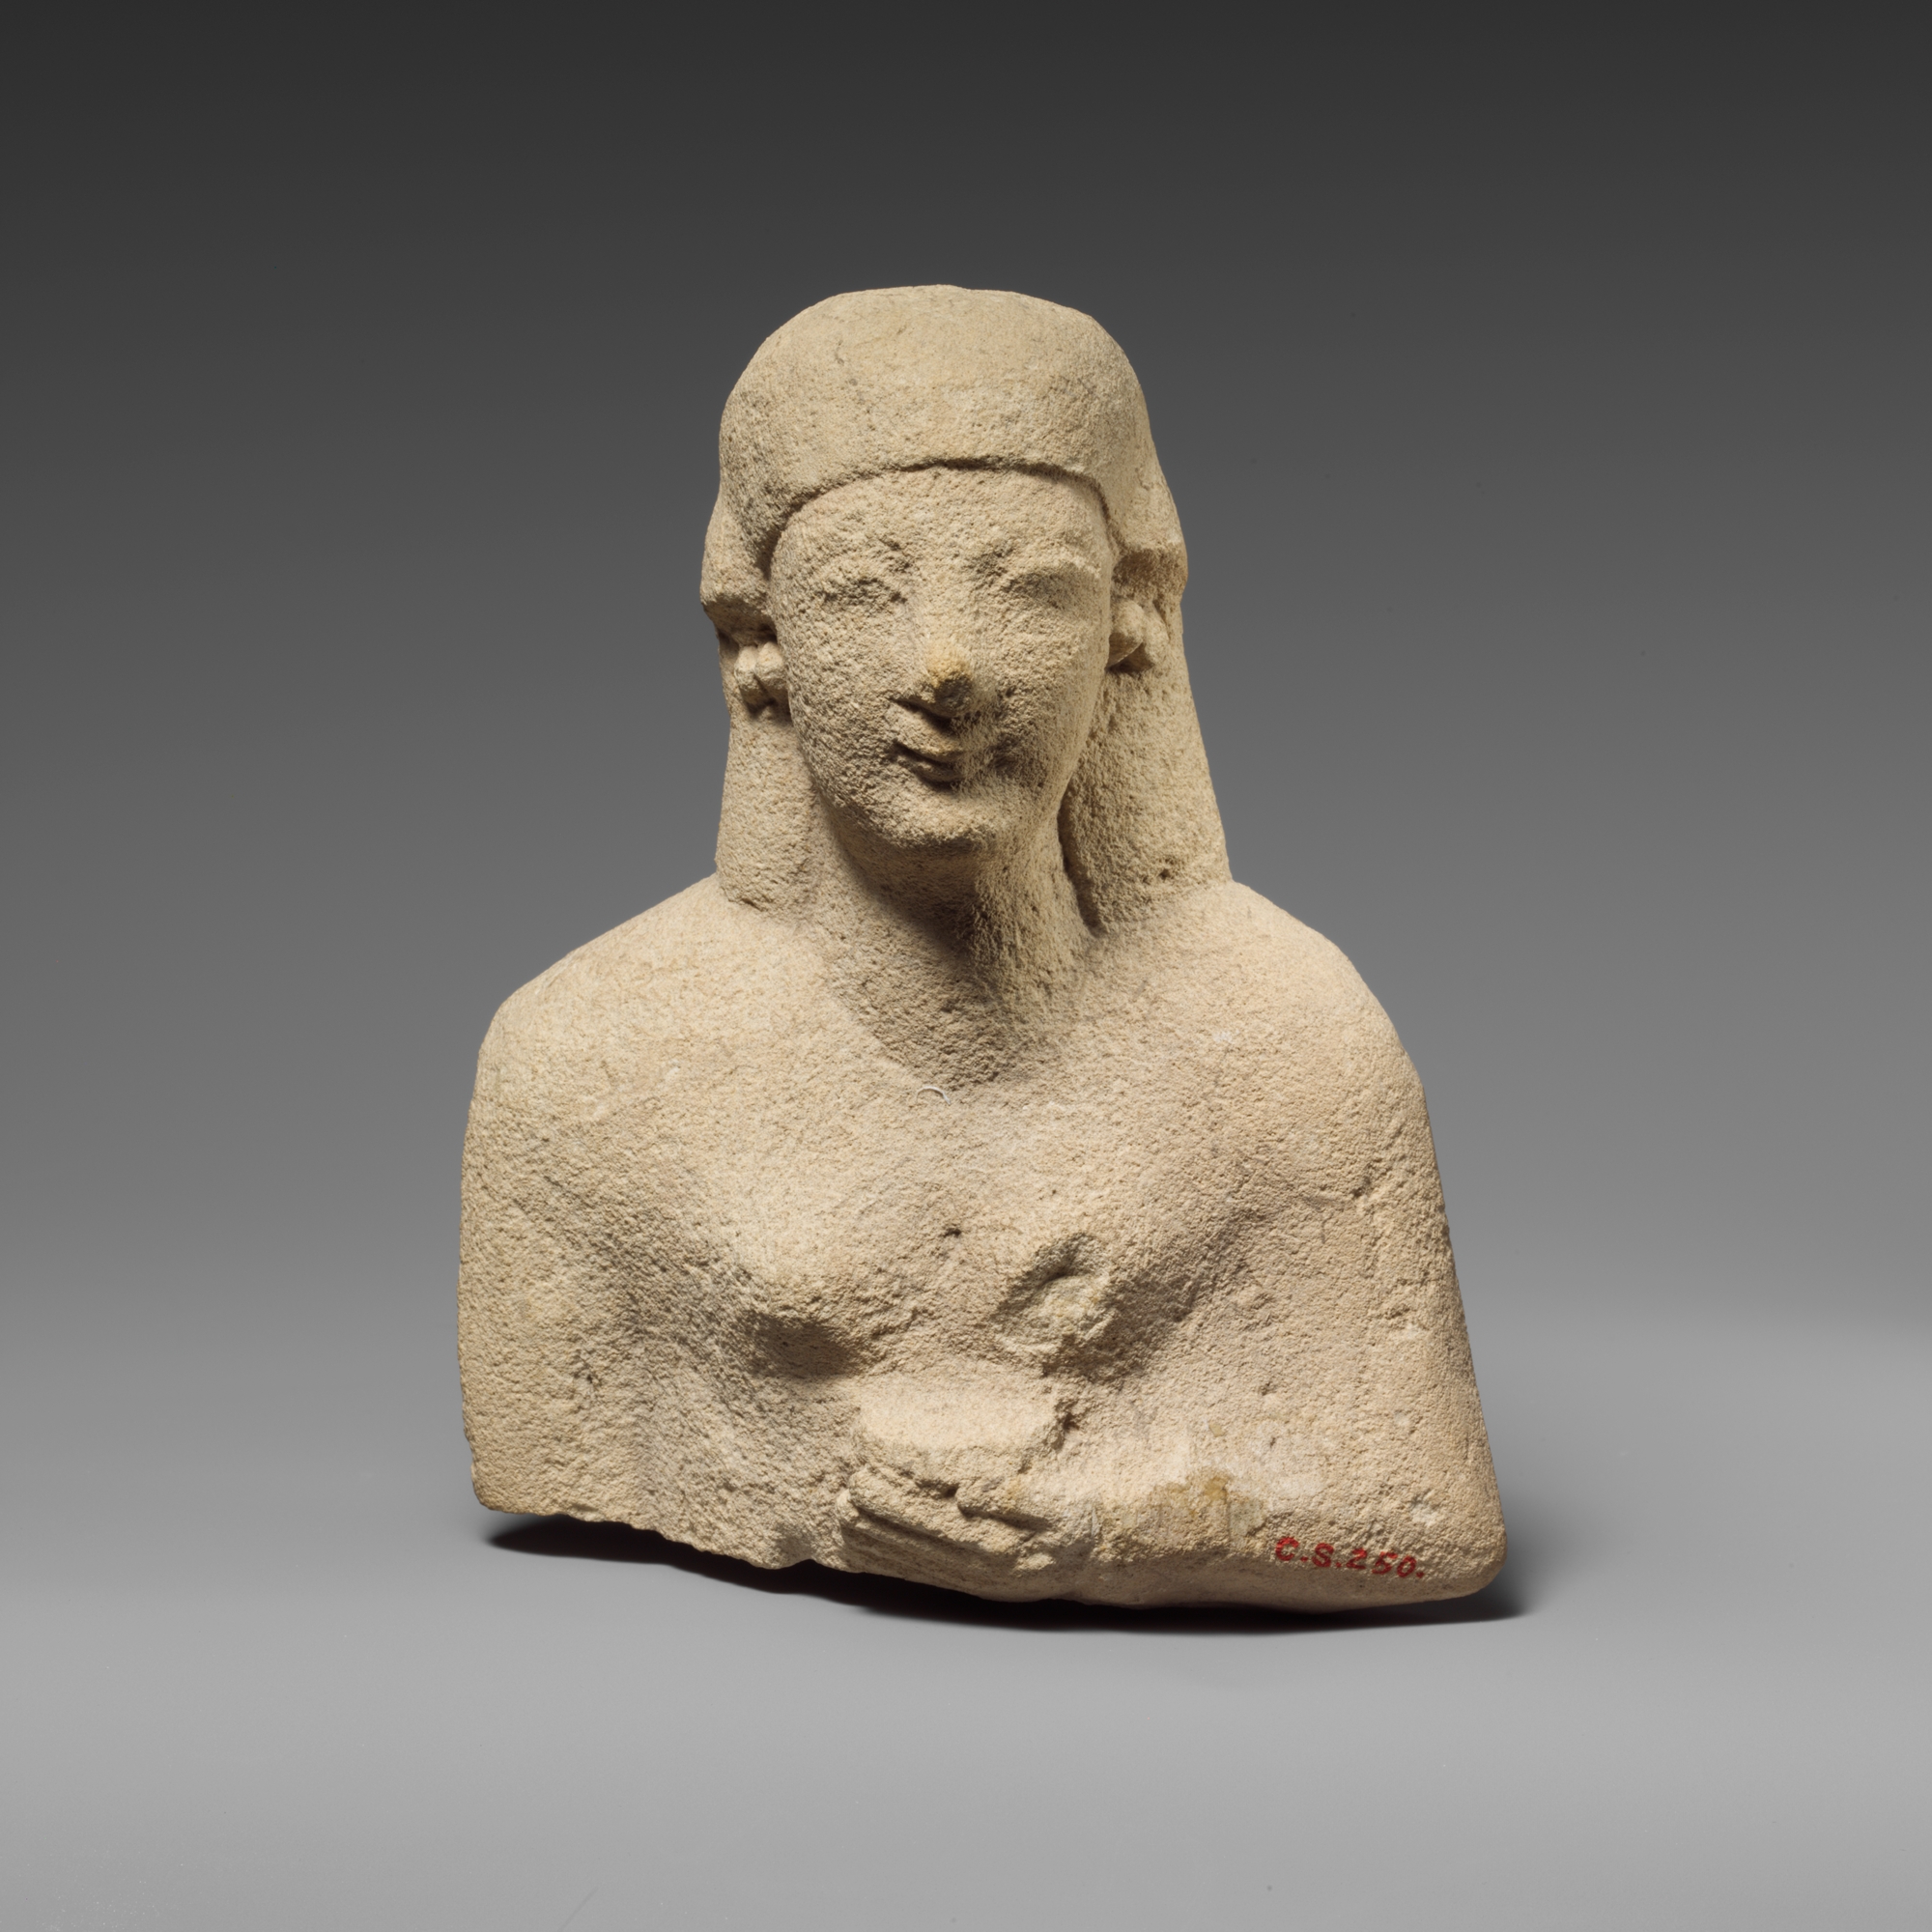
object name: statue of a votary, female, upper part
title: Upper part of a limestone female votary holding a vase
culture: cypriot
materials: limestone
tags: women